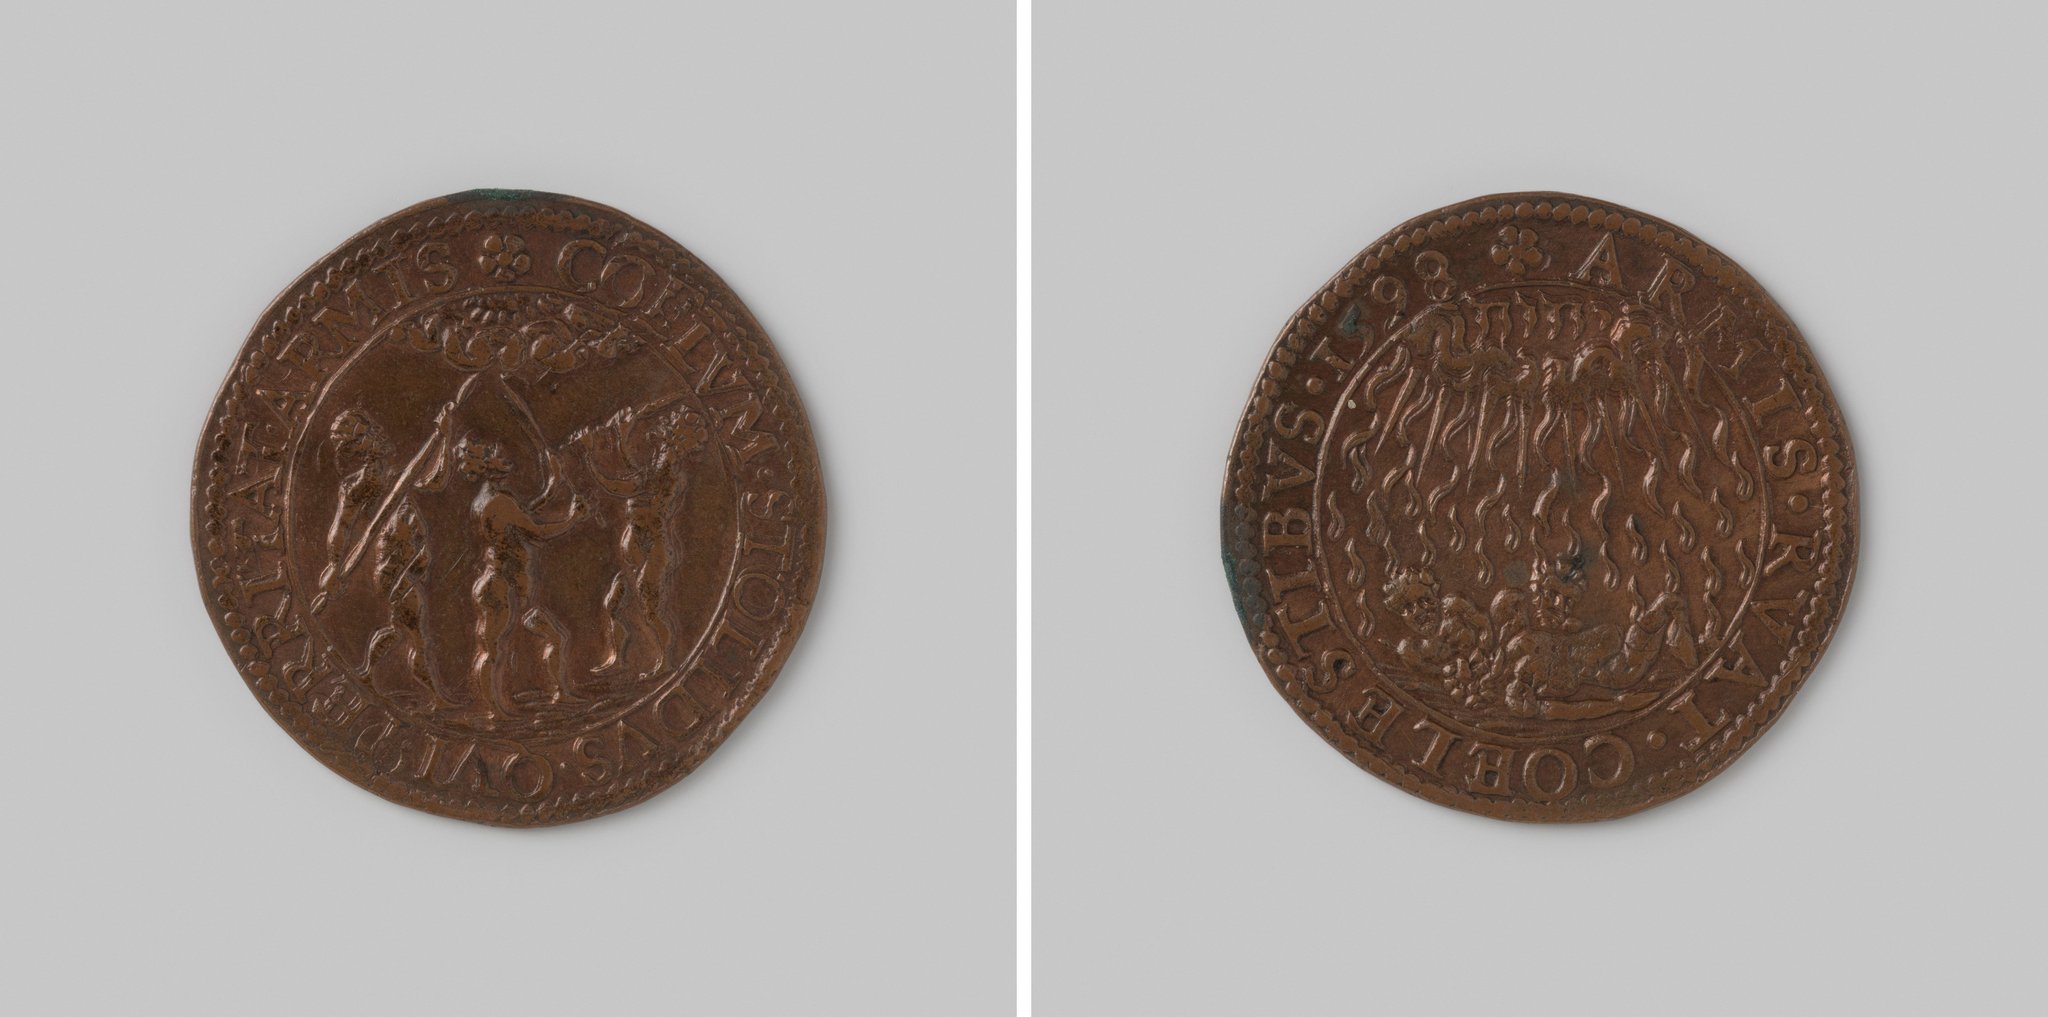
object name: history medal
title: Rekenpenning uit Dordrecht op de wreedheden van Mendoça 1598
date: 1598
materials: copper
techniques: striking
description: Koperen penning, op de voorzijde drie reuzen die de hemel bestoken, met omschrift, op de keerzijde de reuzen geveld door het hemelse vuur, met omschrift.